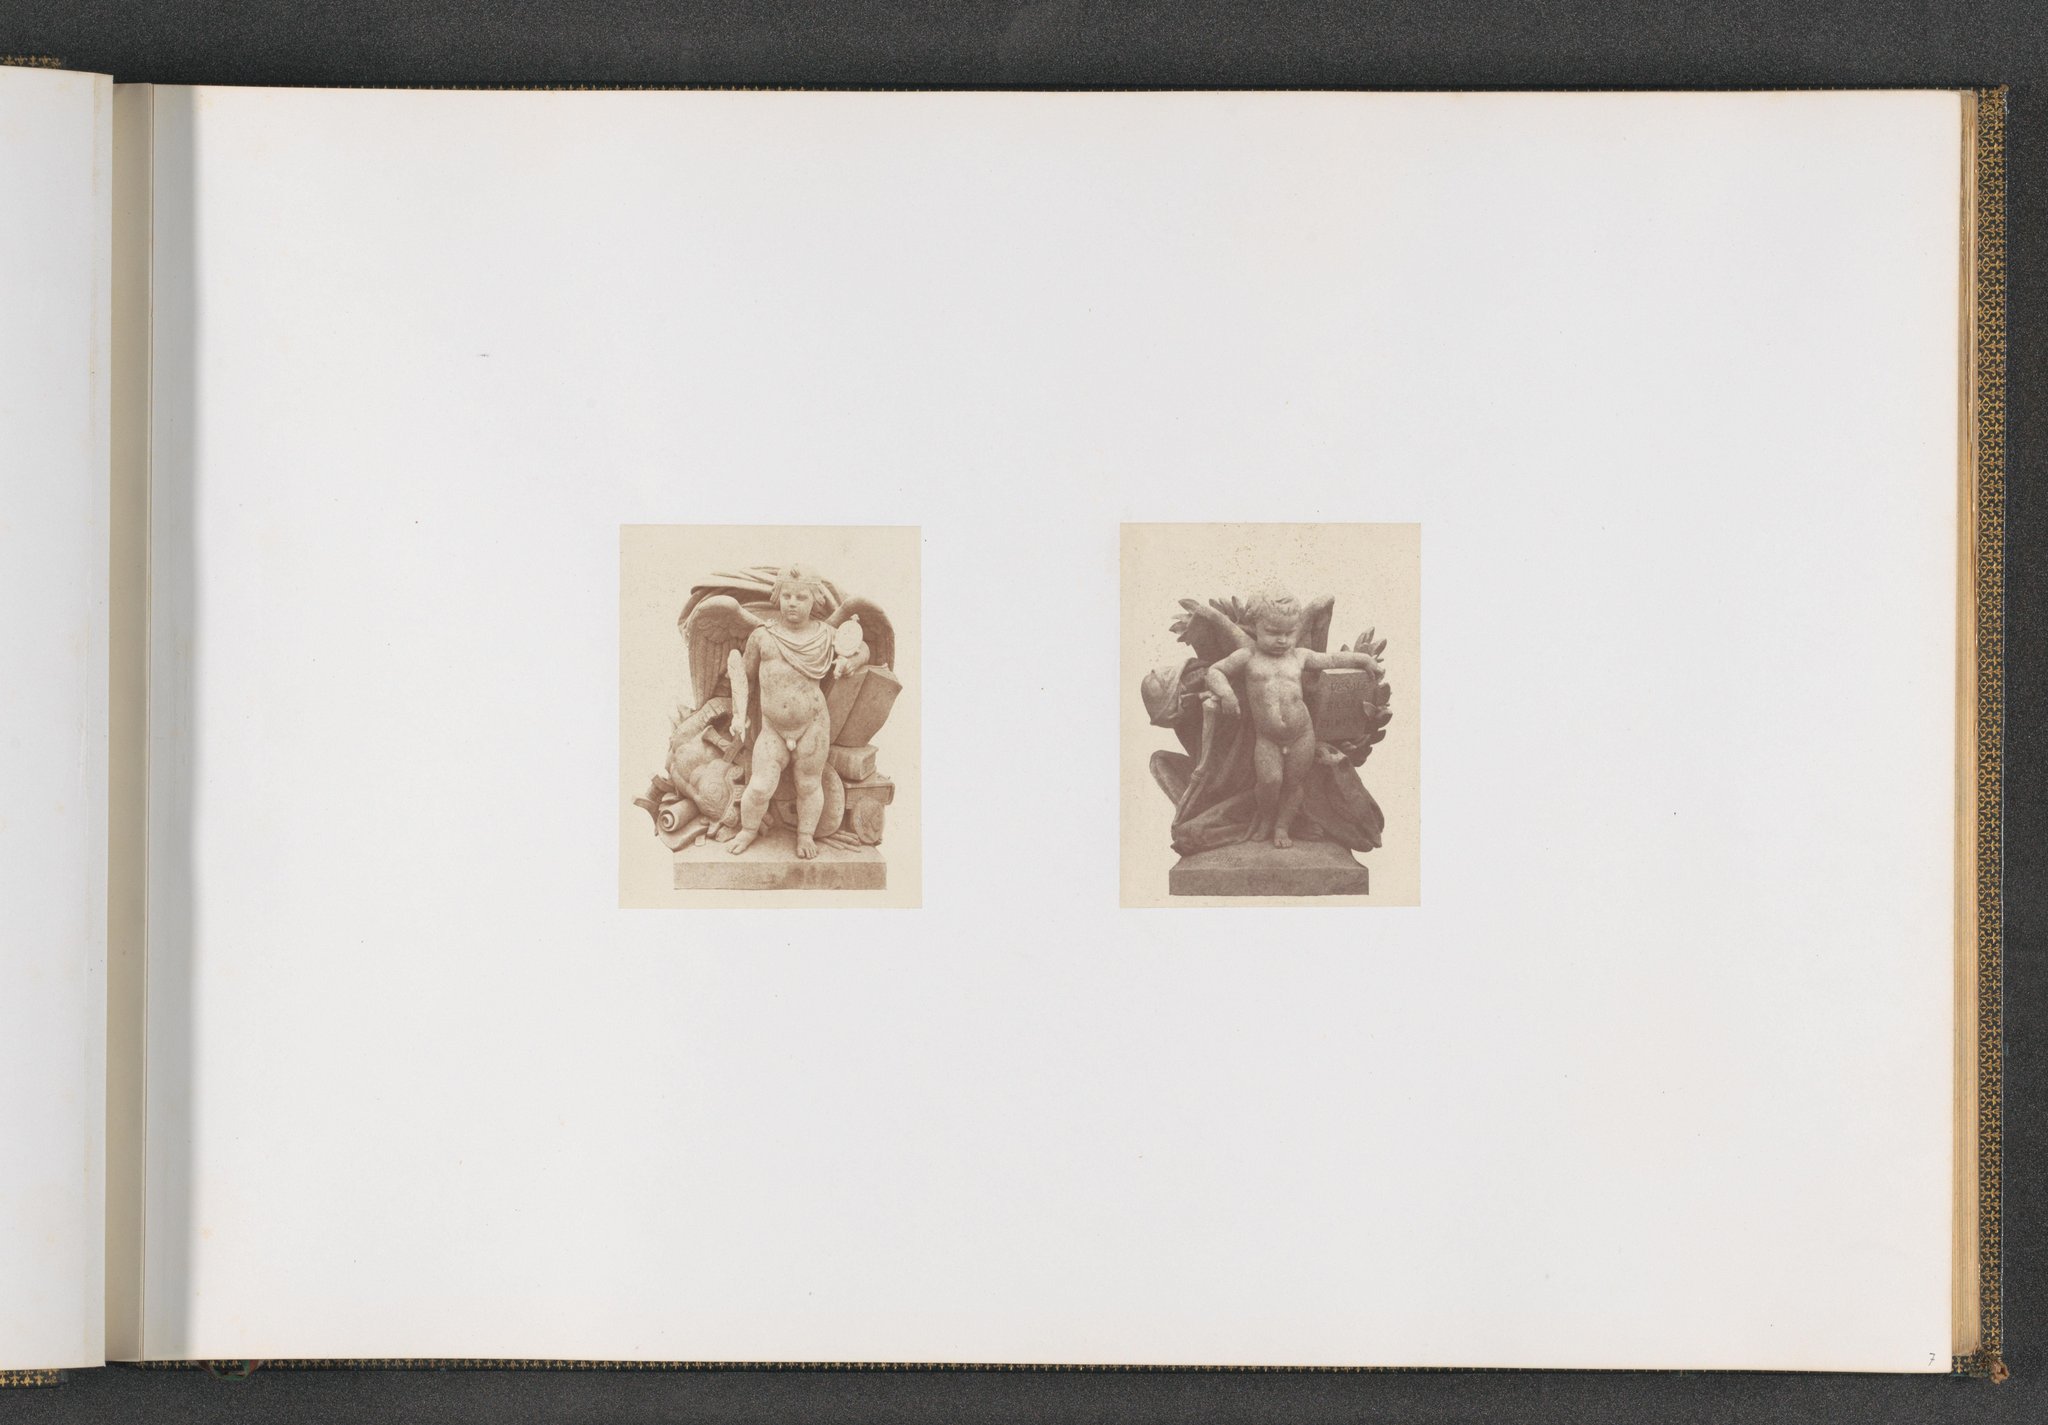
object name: album leaf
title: Gipsmodellen voor beeldhouwwerken op het Palais du Louvre: links "L'Histoire" door Théodore François Devaulx en rechts "L'Anatomie" door Emile Hébert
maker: édouard denis baldus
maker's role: fotograaf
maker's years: 1813-1889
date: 1855-1857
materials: paper, photographic support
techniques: salted paper print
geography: paris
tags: piece of sculpture, reproduction of a piece of sculpture, permanent exhibition, museum, paris, tuileries palace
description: Onderdeel van Réunion des Tuileries au Louvre 1852-1857, album 2.